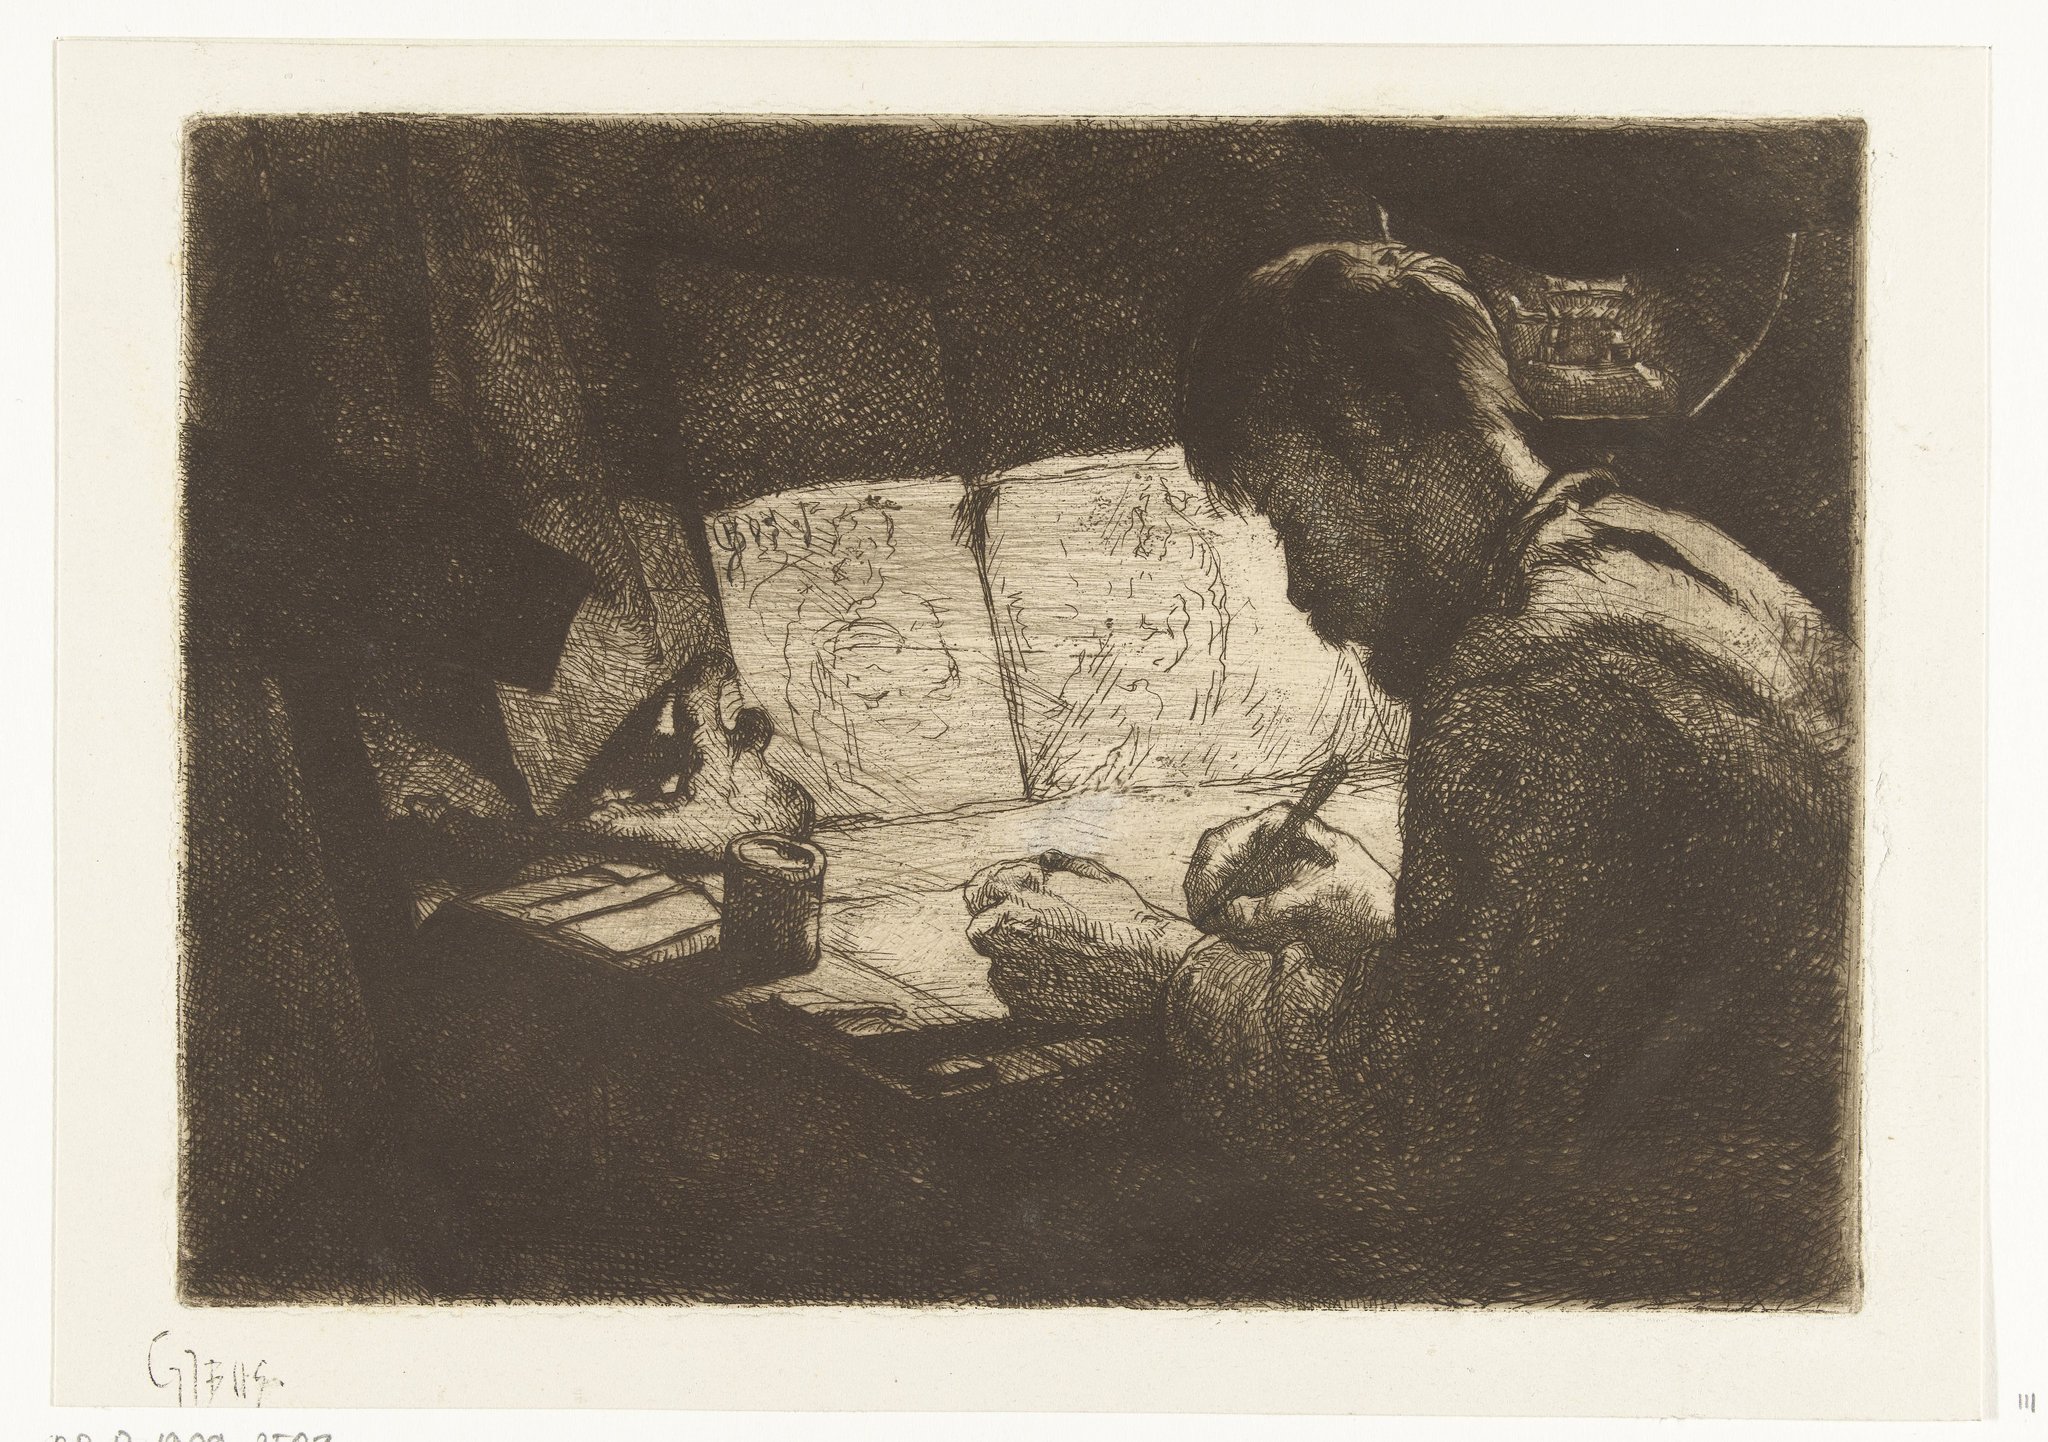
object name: print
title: Zelfportret achter de tekentafel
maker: gerard jan bos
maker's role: print maker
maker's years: 1860-1943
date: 1883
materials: paper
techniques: drypoint, etching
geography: antwerp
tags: utrecht, print maker, gerard jan bos, portrait, self-portrait of artist (+ in workshop or studio)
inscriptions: signature: ‘GJBos.’, collector's mark: Lugt 2228